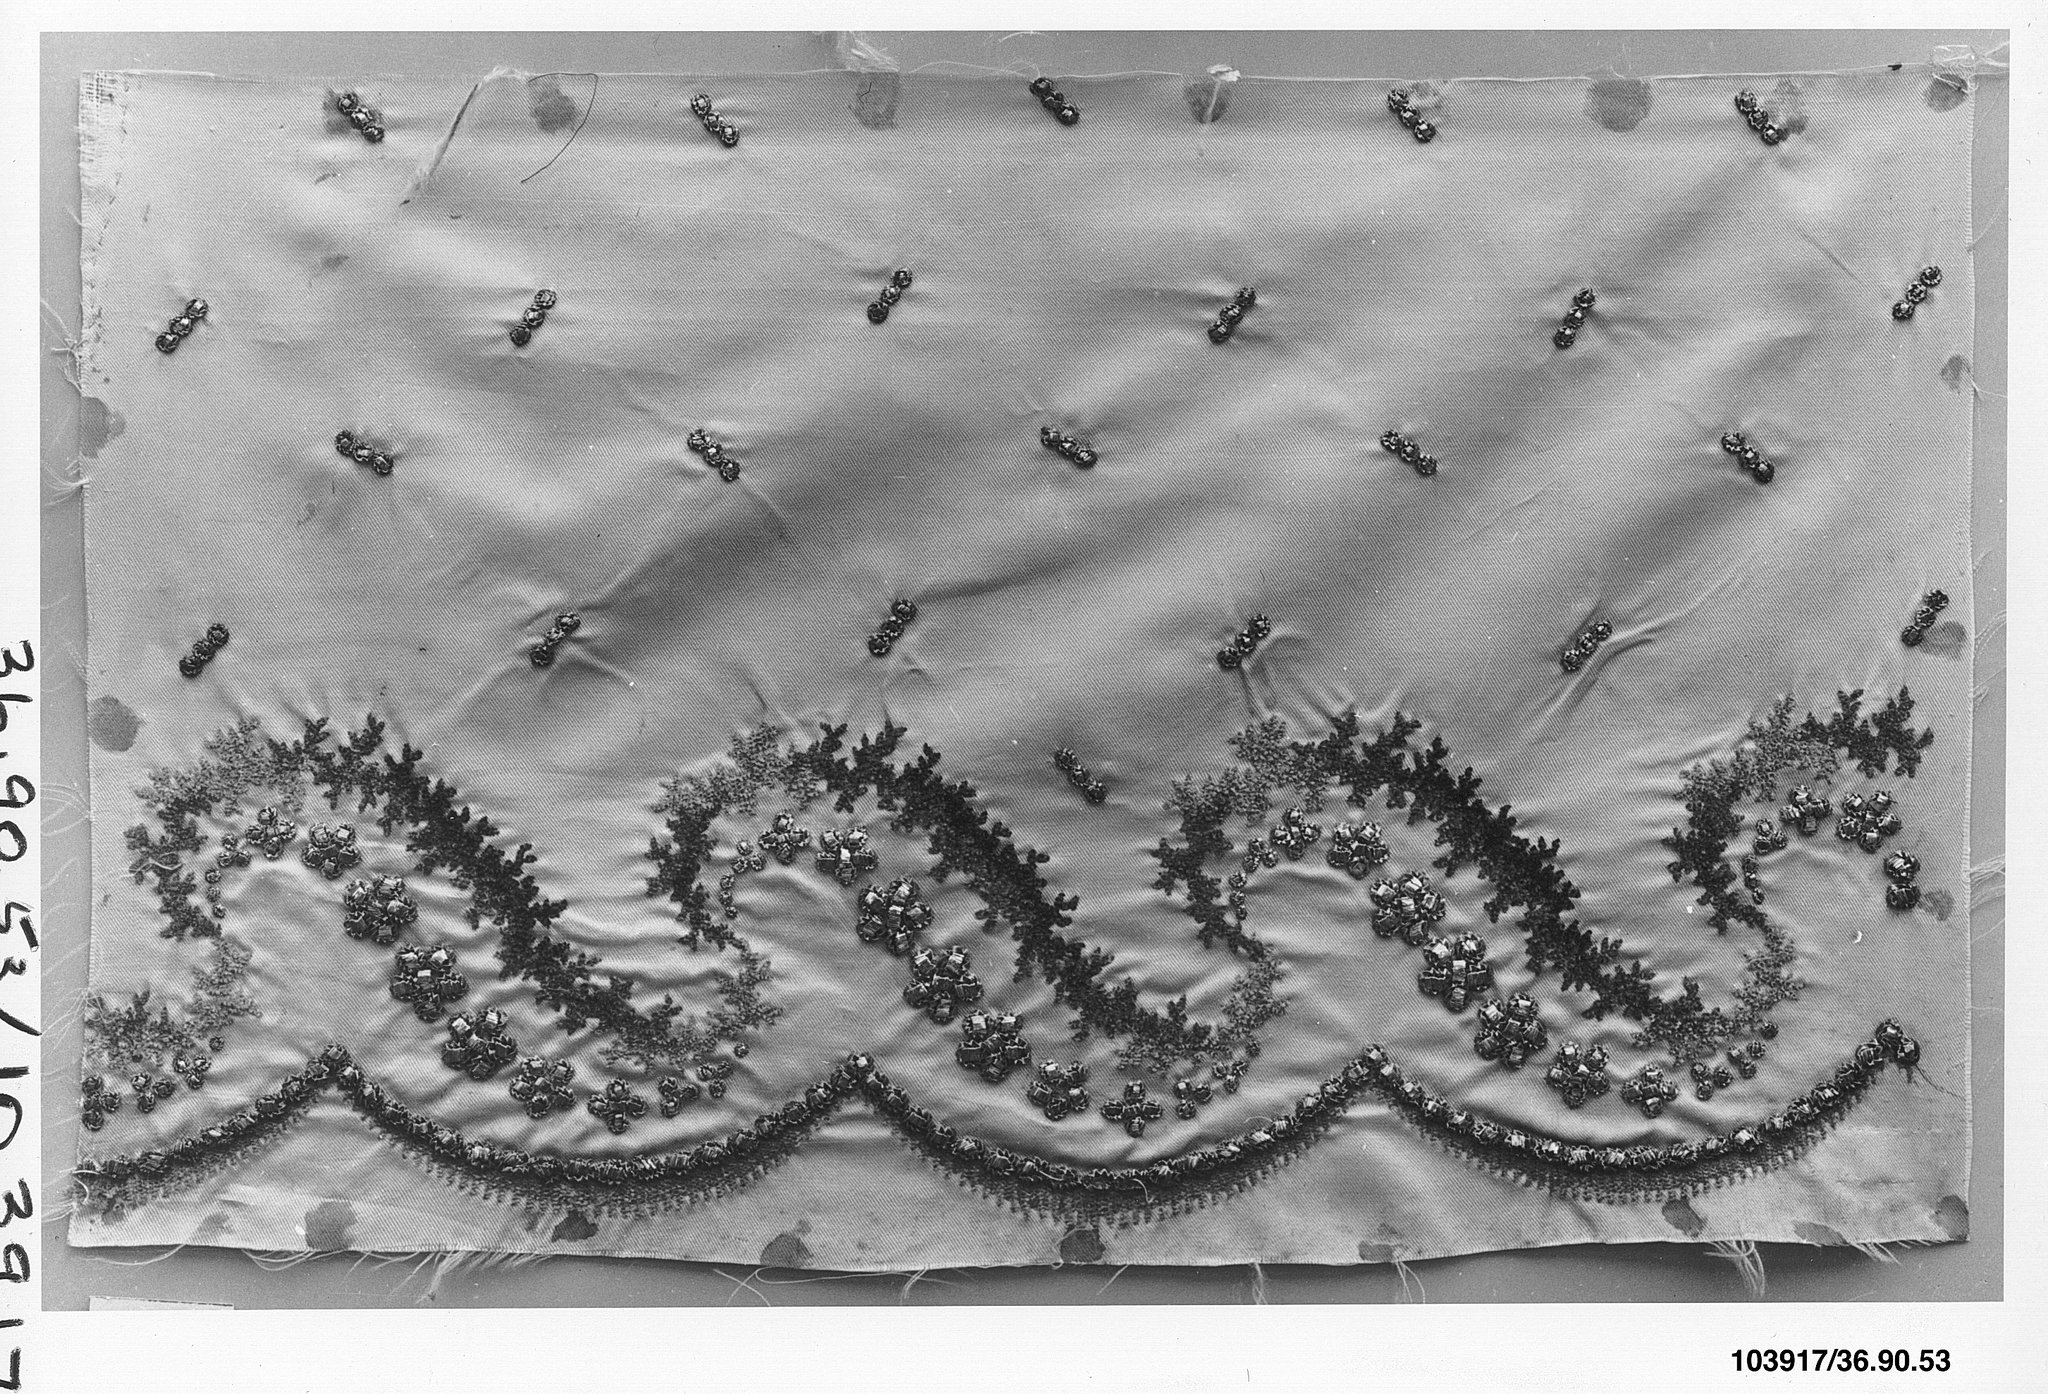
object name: border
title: Dress border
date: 1801-1833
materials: metal thread, silk